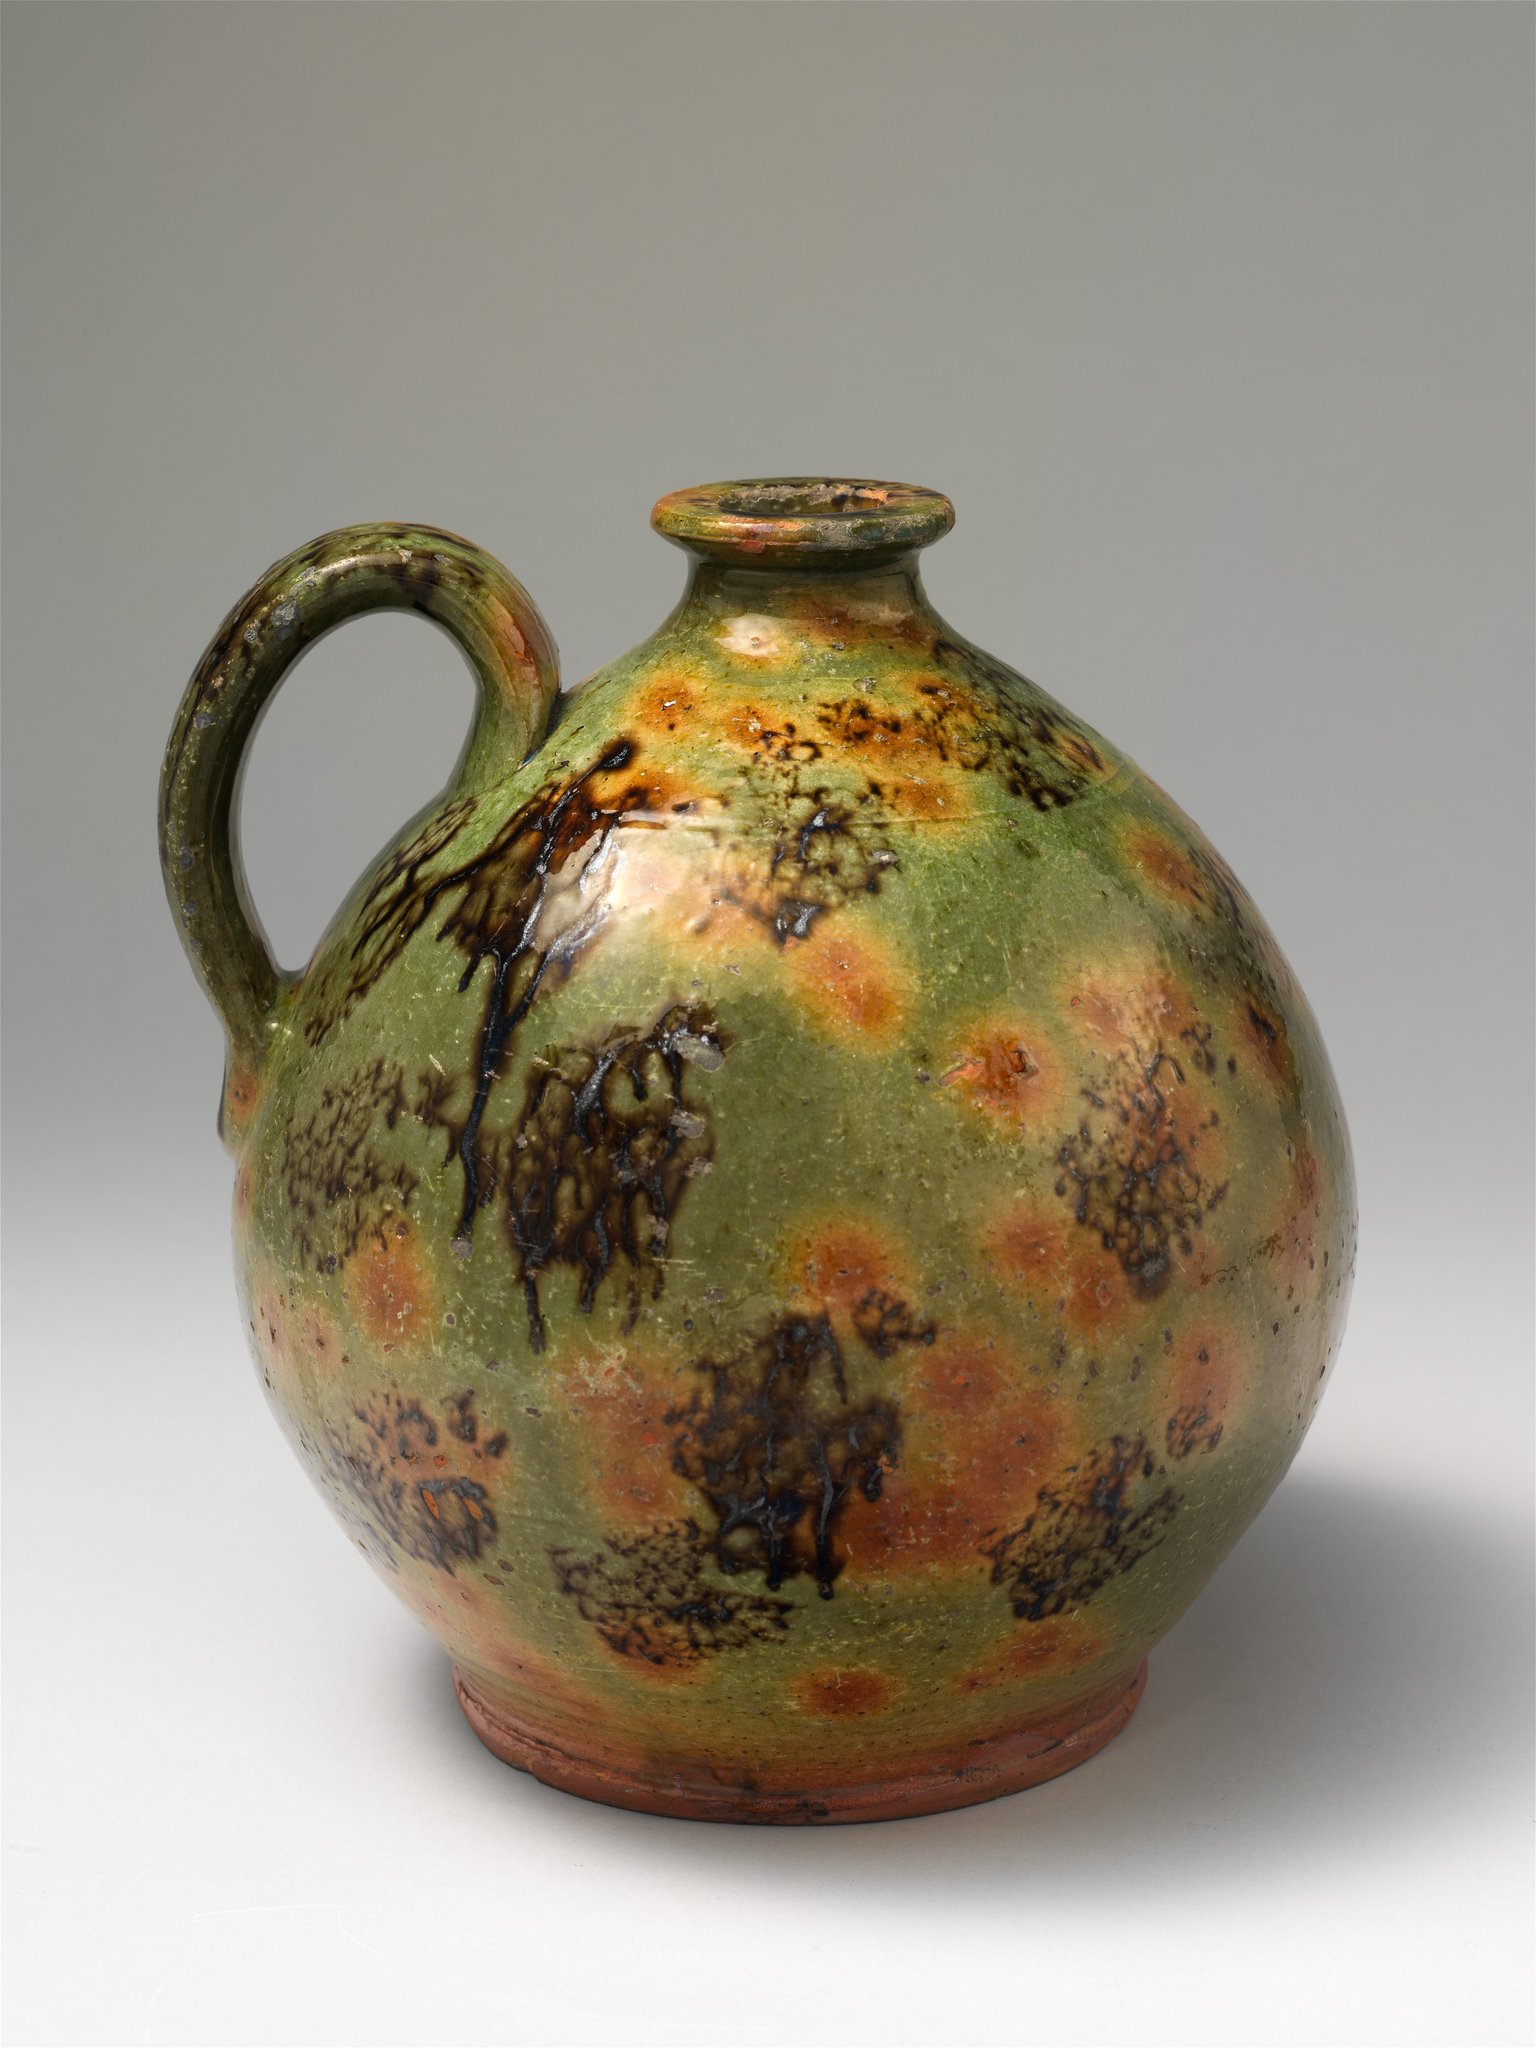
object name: jug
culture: american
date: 1800-1840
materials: earthenware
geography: united states